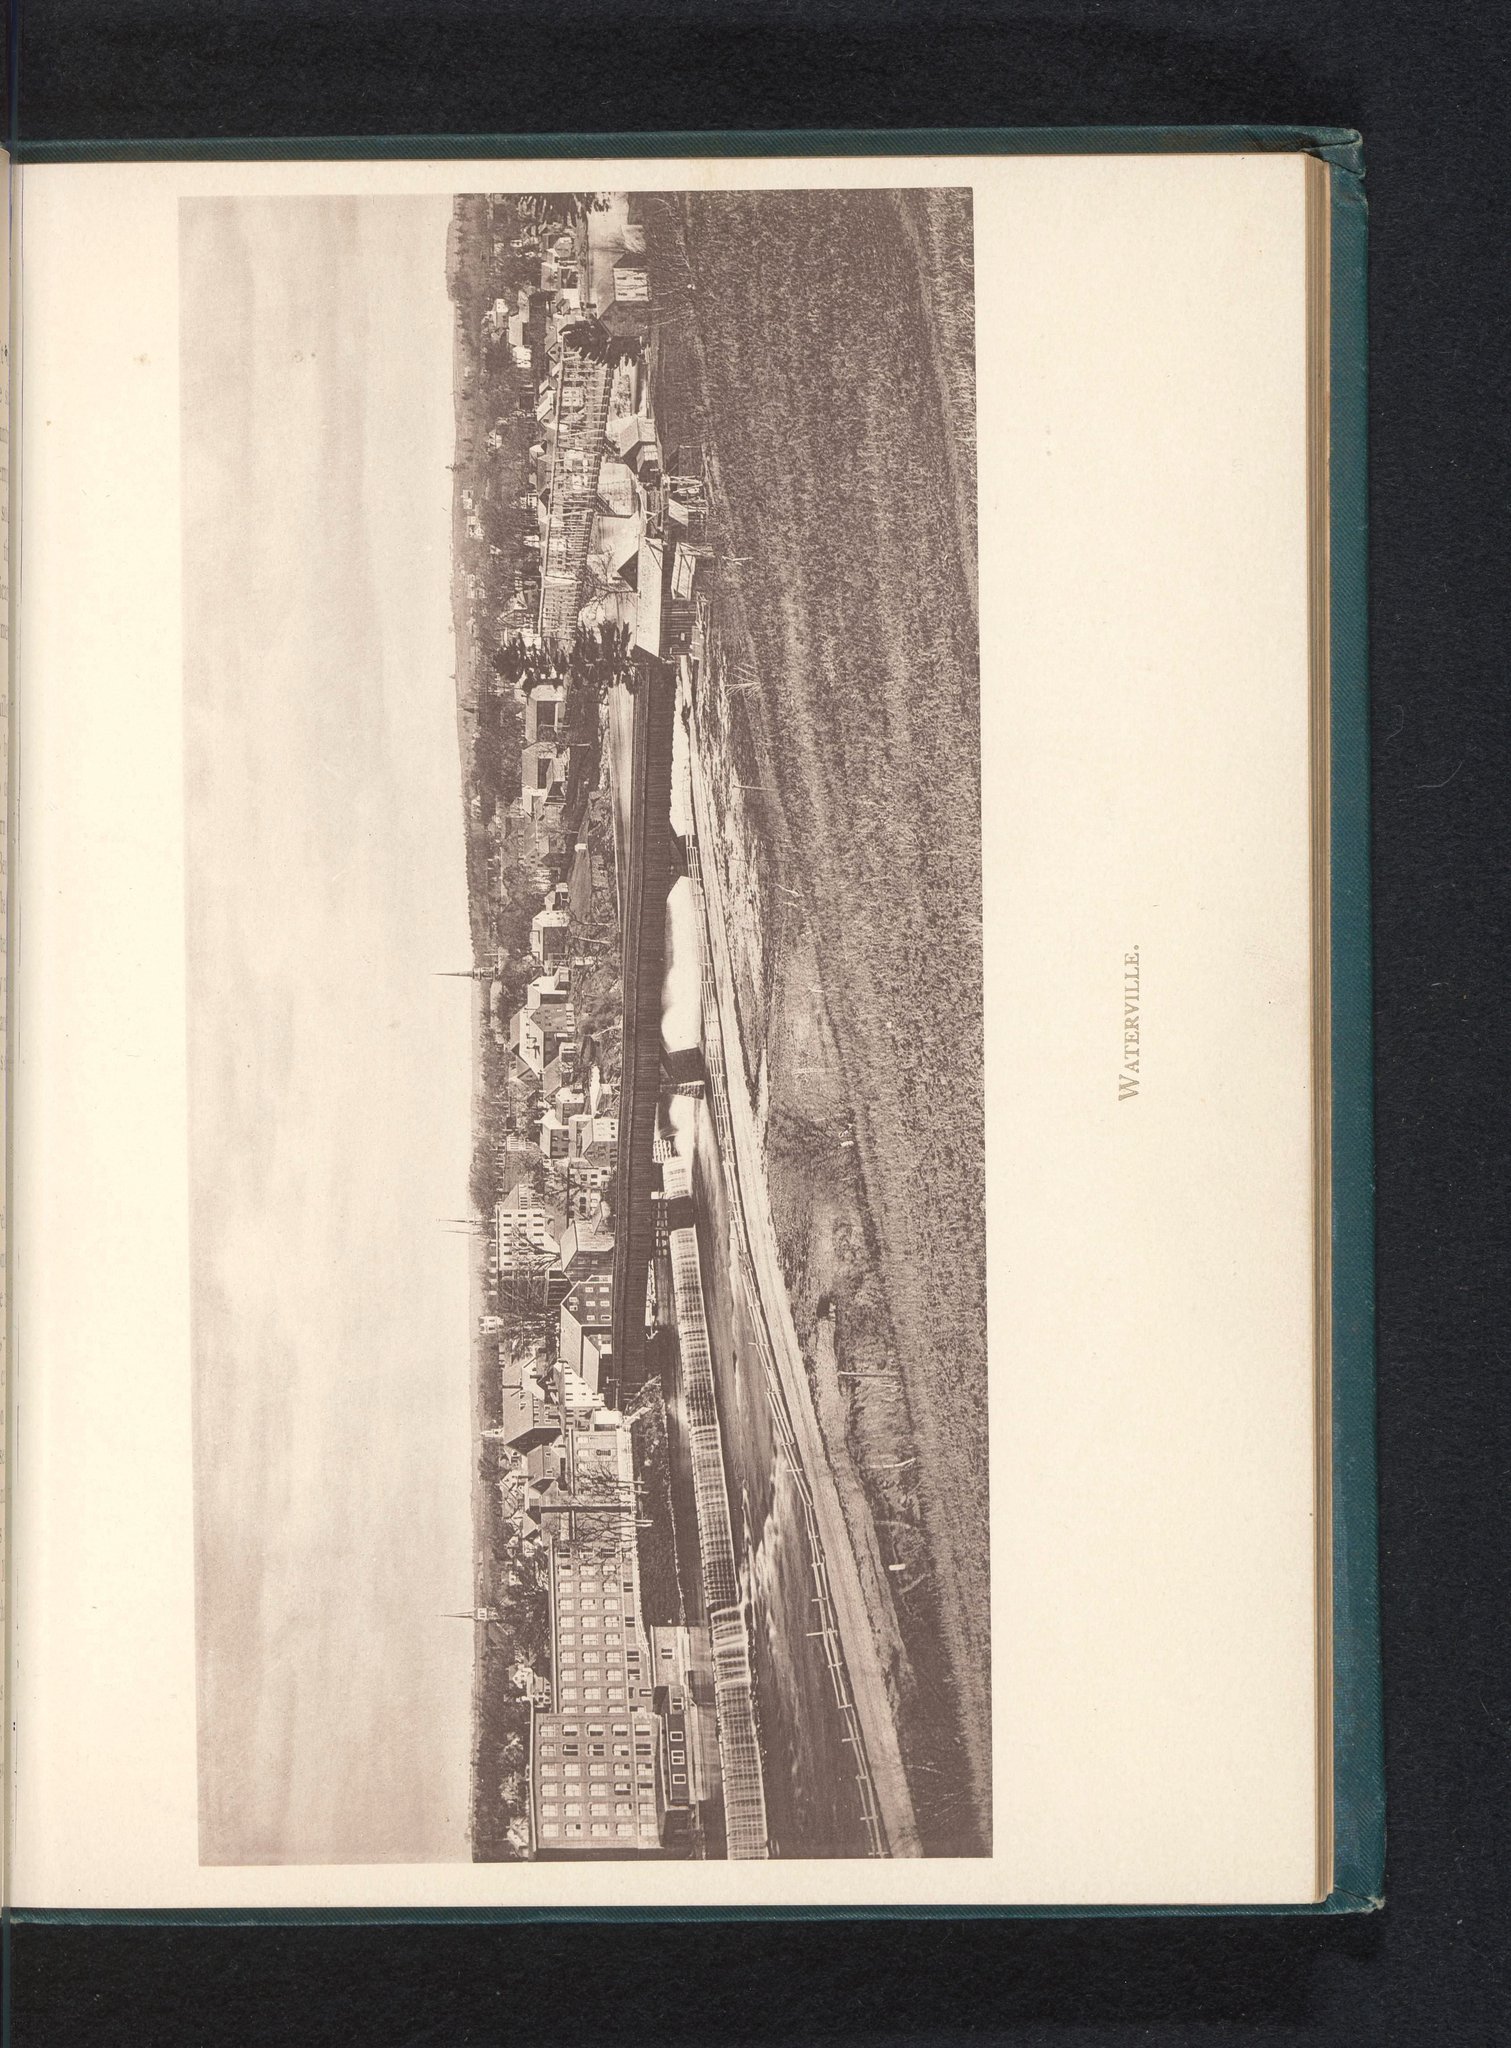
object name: photomechanical print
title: Waterville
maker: Anonymous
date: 1875-1880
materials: paper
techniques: photograph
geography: waterville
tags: city-view, and landscape with man-made constructions